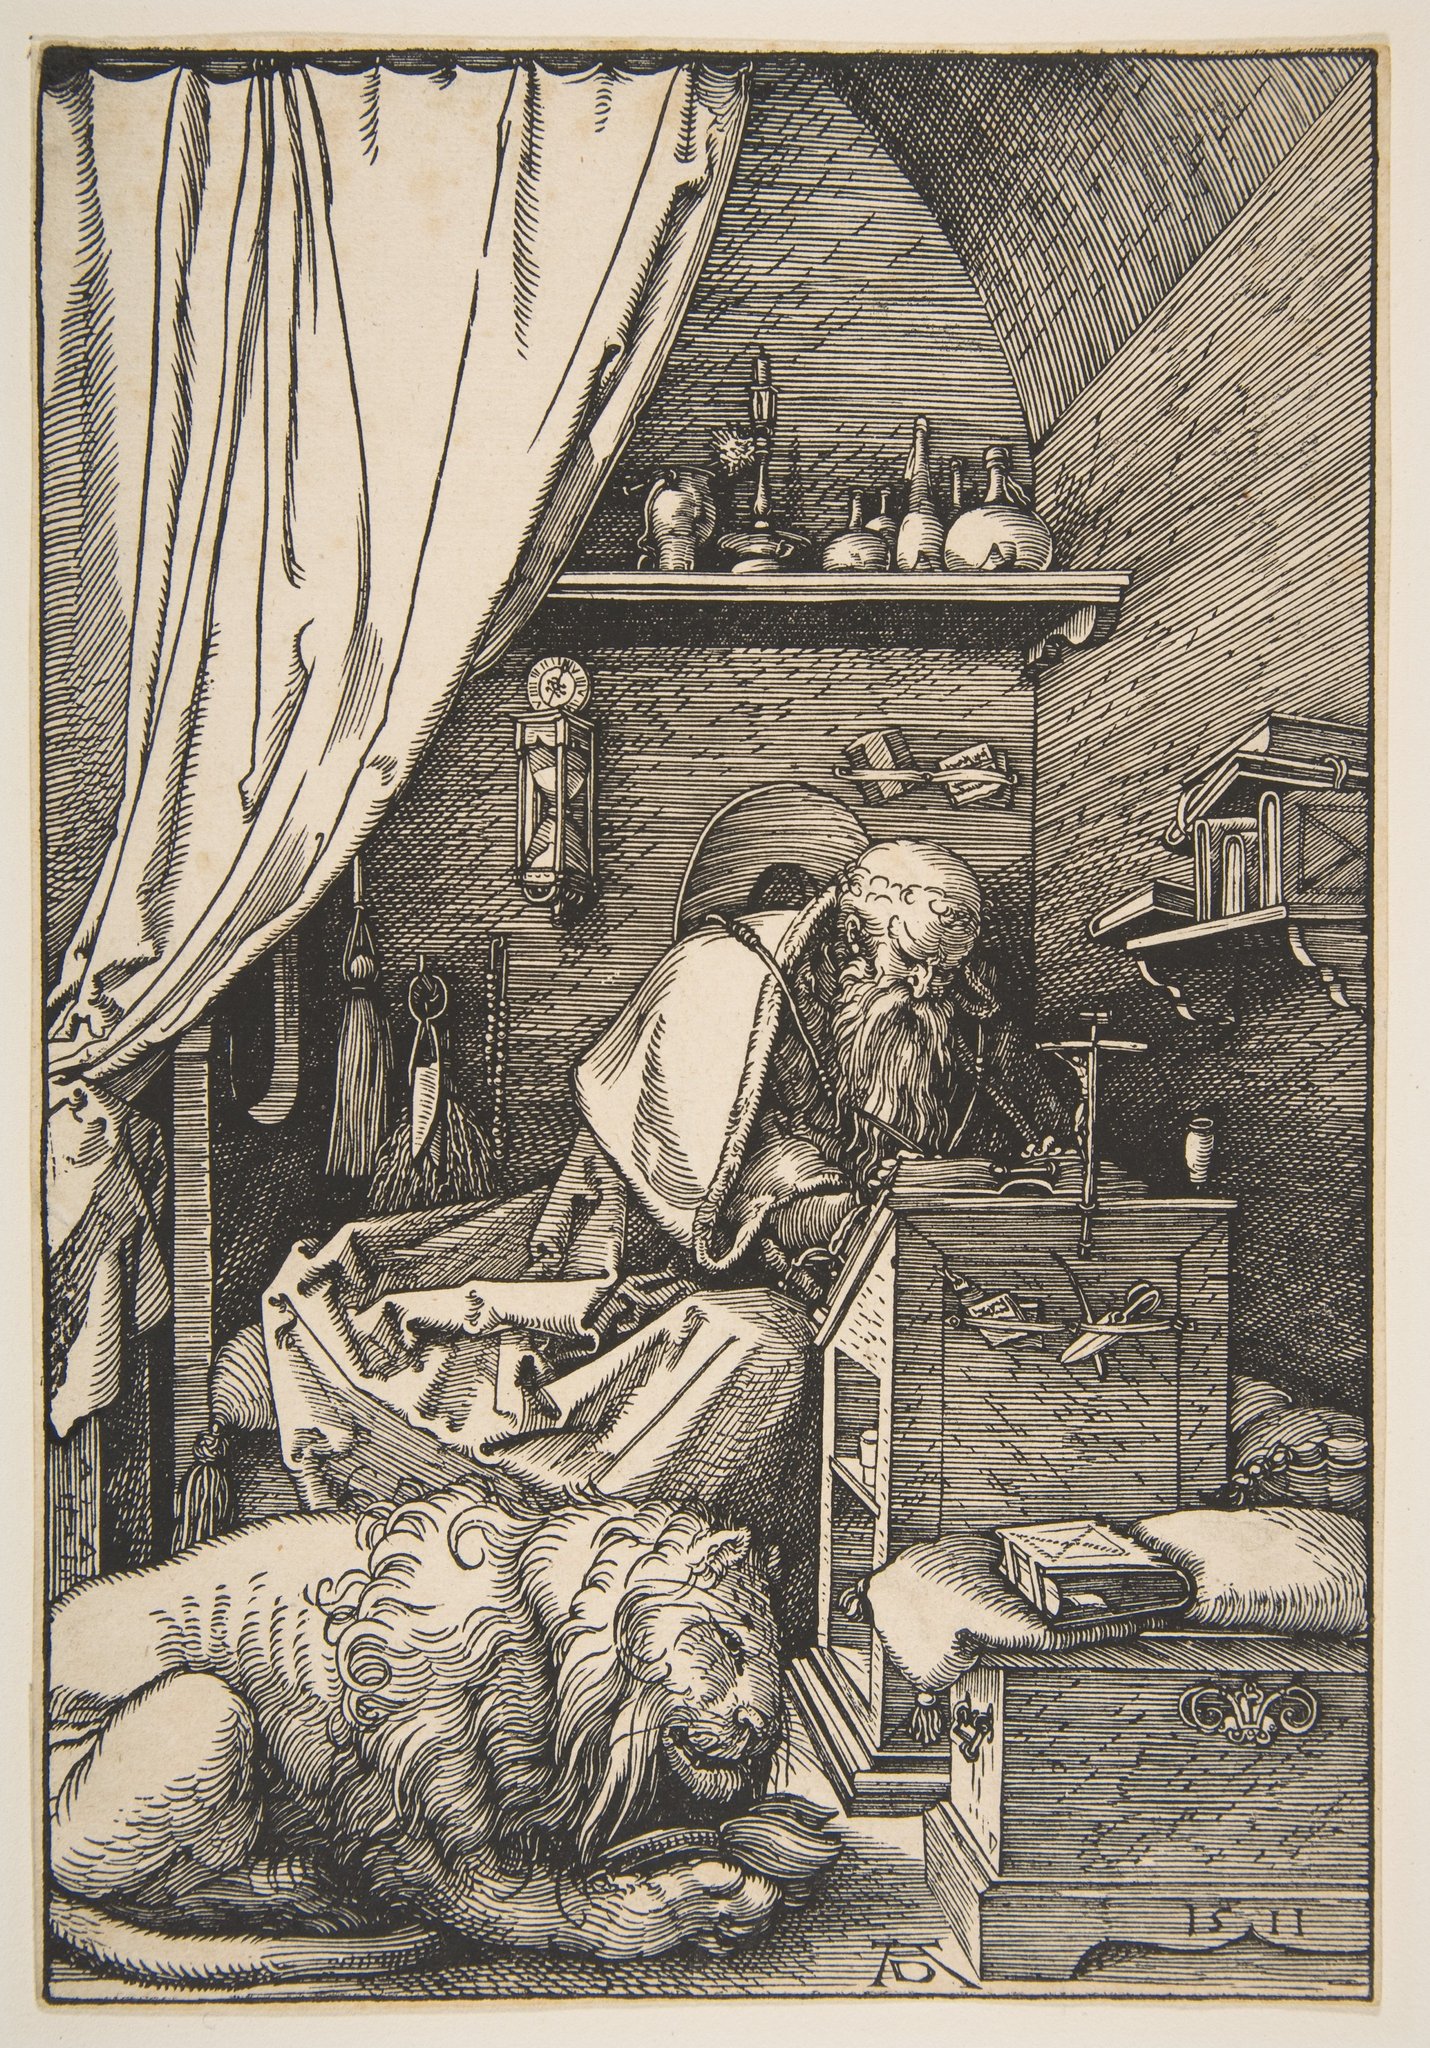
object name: print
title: Saint Jerome in His Study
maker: albrecht dürer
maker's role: artist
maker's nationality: german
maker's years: 1471-1528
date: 1514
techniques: woodcut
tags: reading,lions,saint jerome